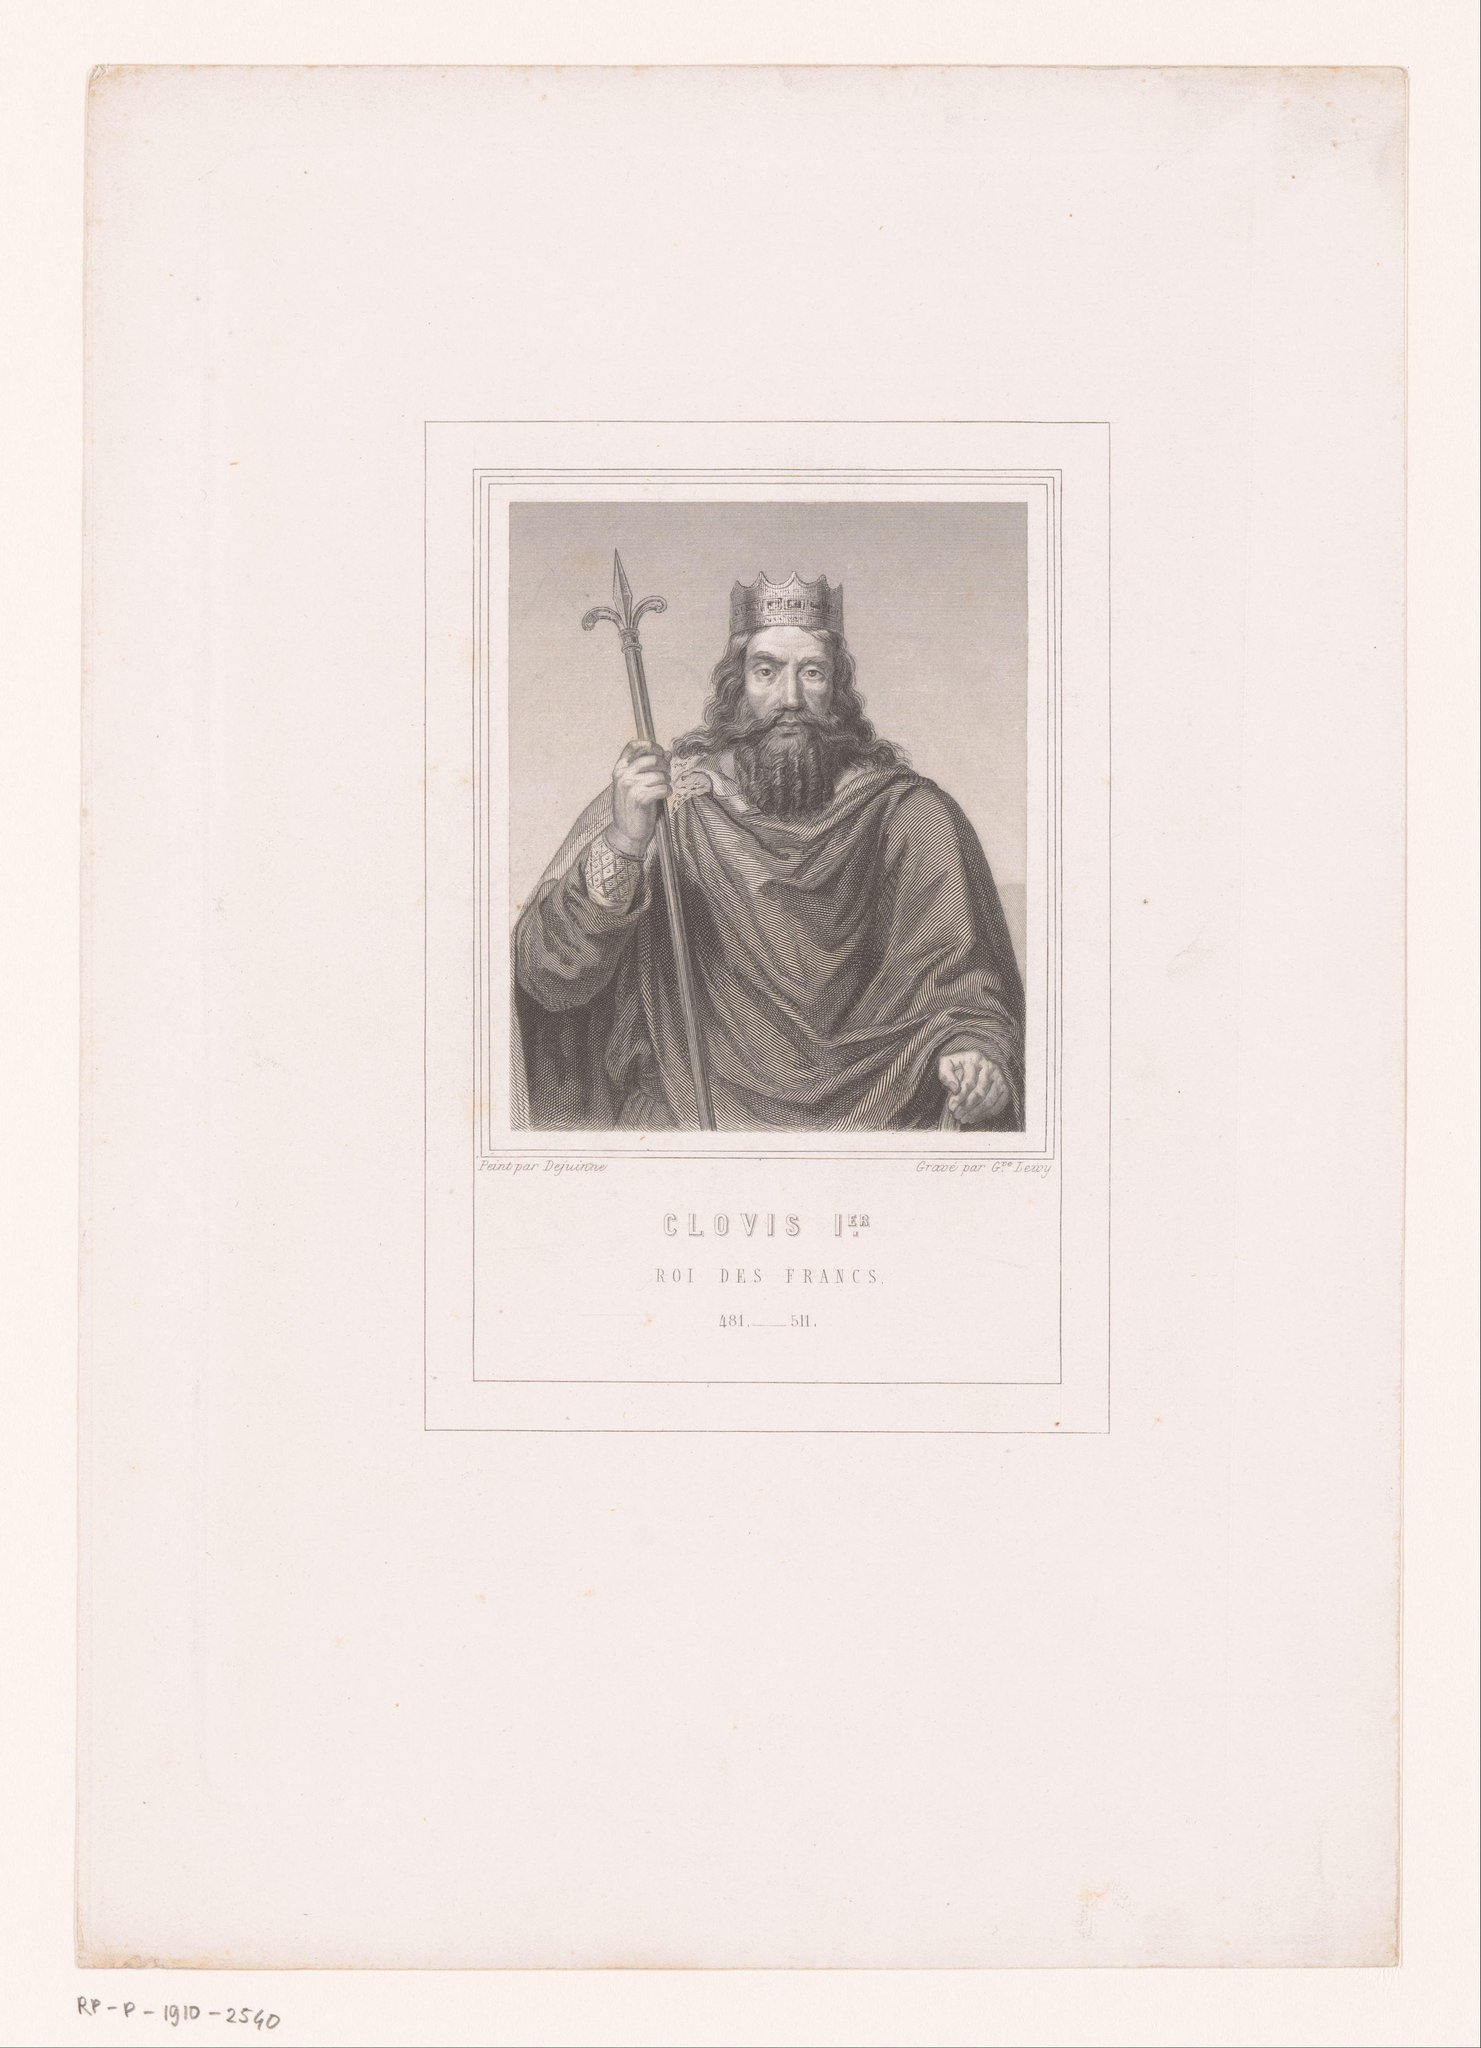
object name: print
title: Clovis Ier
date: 1829-1894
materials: paper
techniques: engraving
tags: paris, historical persons, king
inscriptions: collector's mark: Lugt 2228